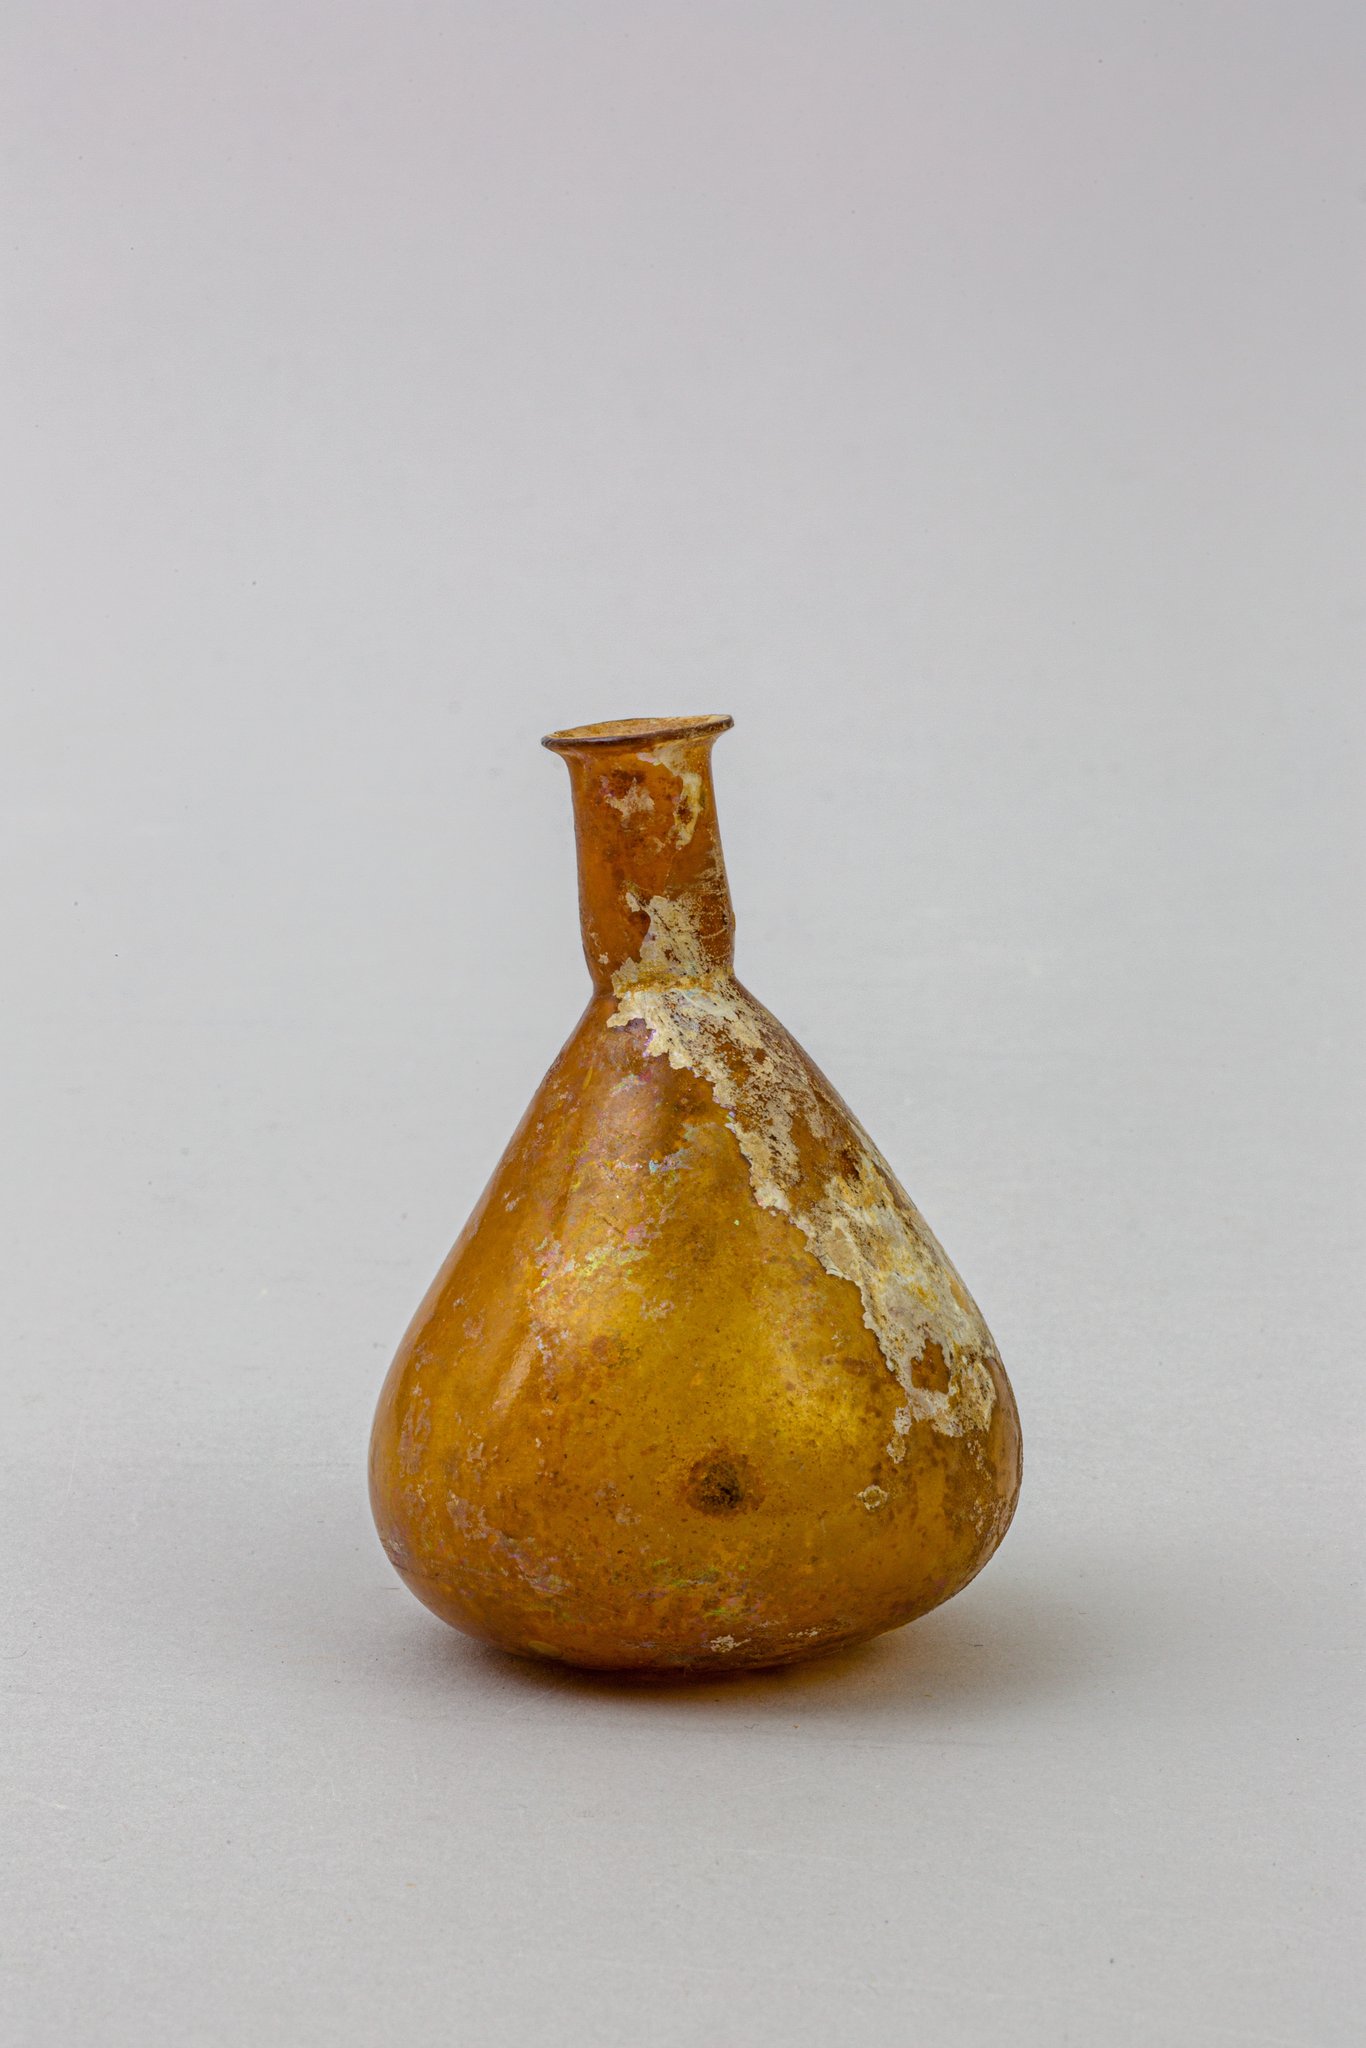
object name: perfume bottle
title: Glass perfume bottle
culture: roman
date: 1-100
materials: glass